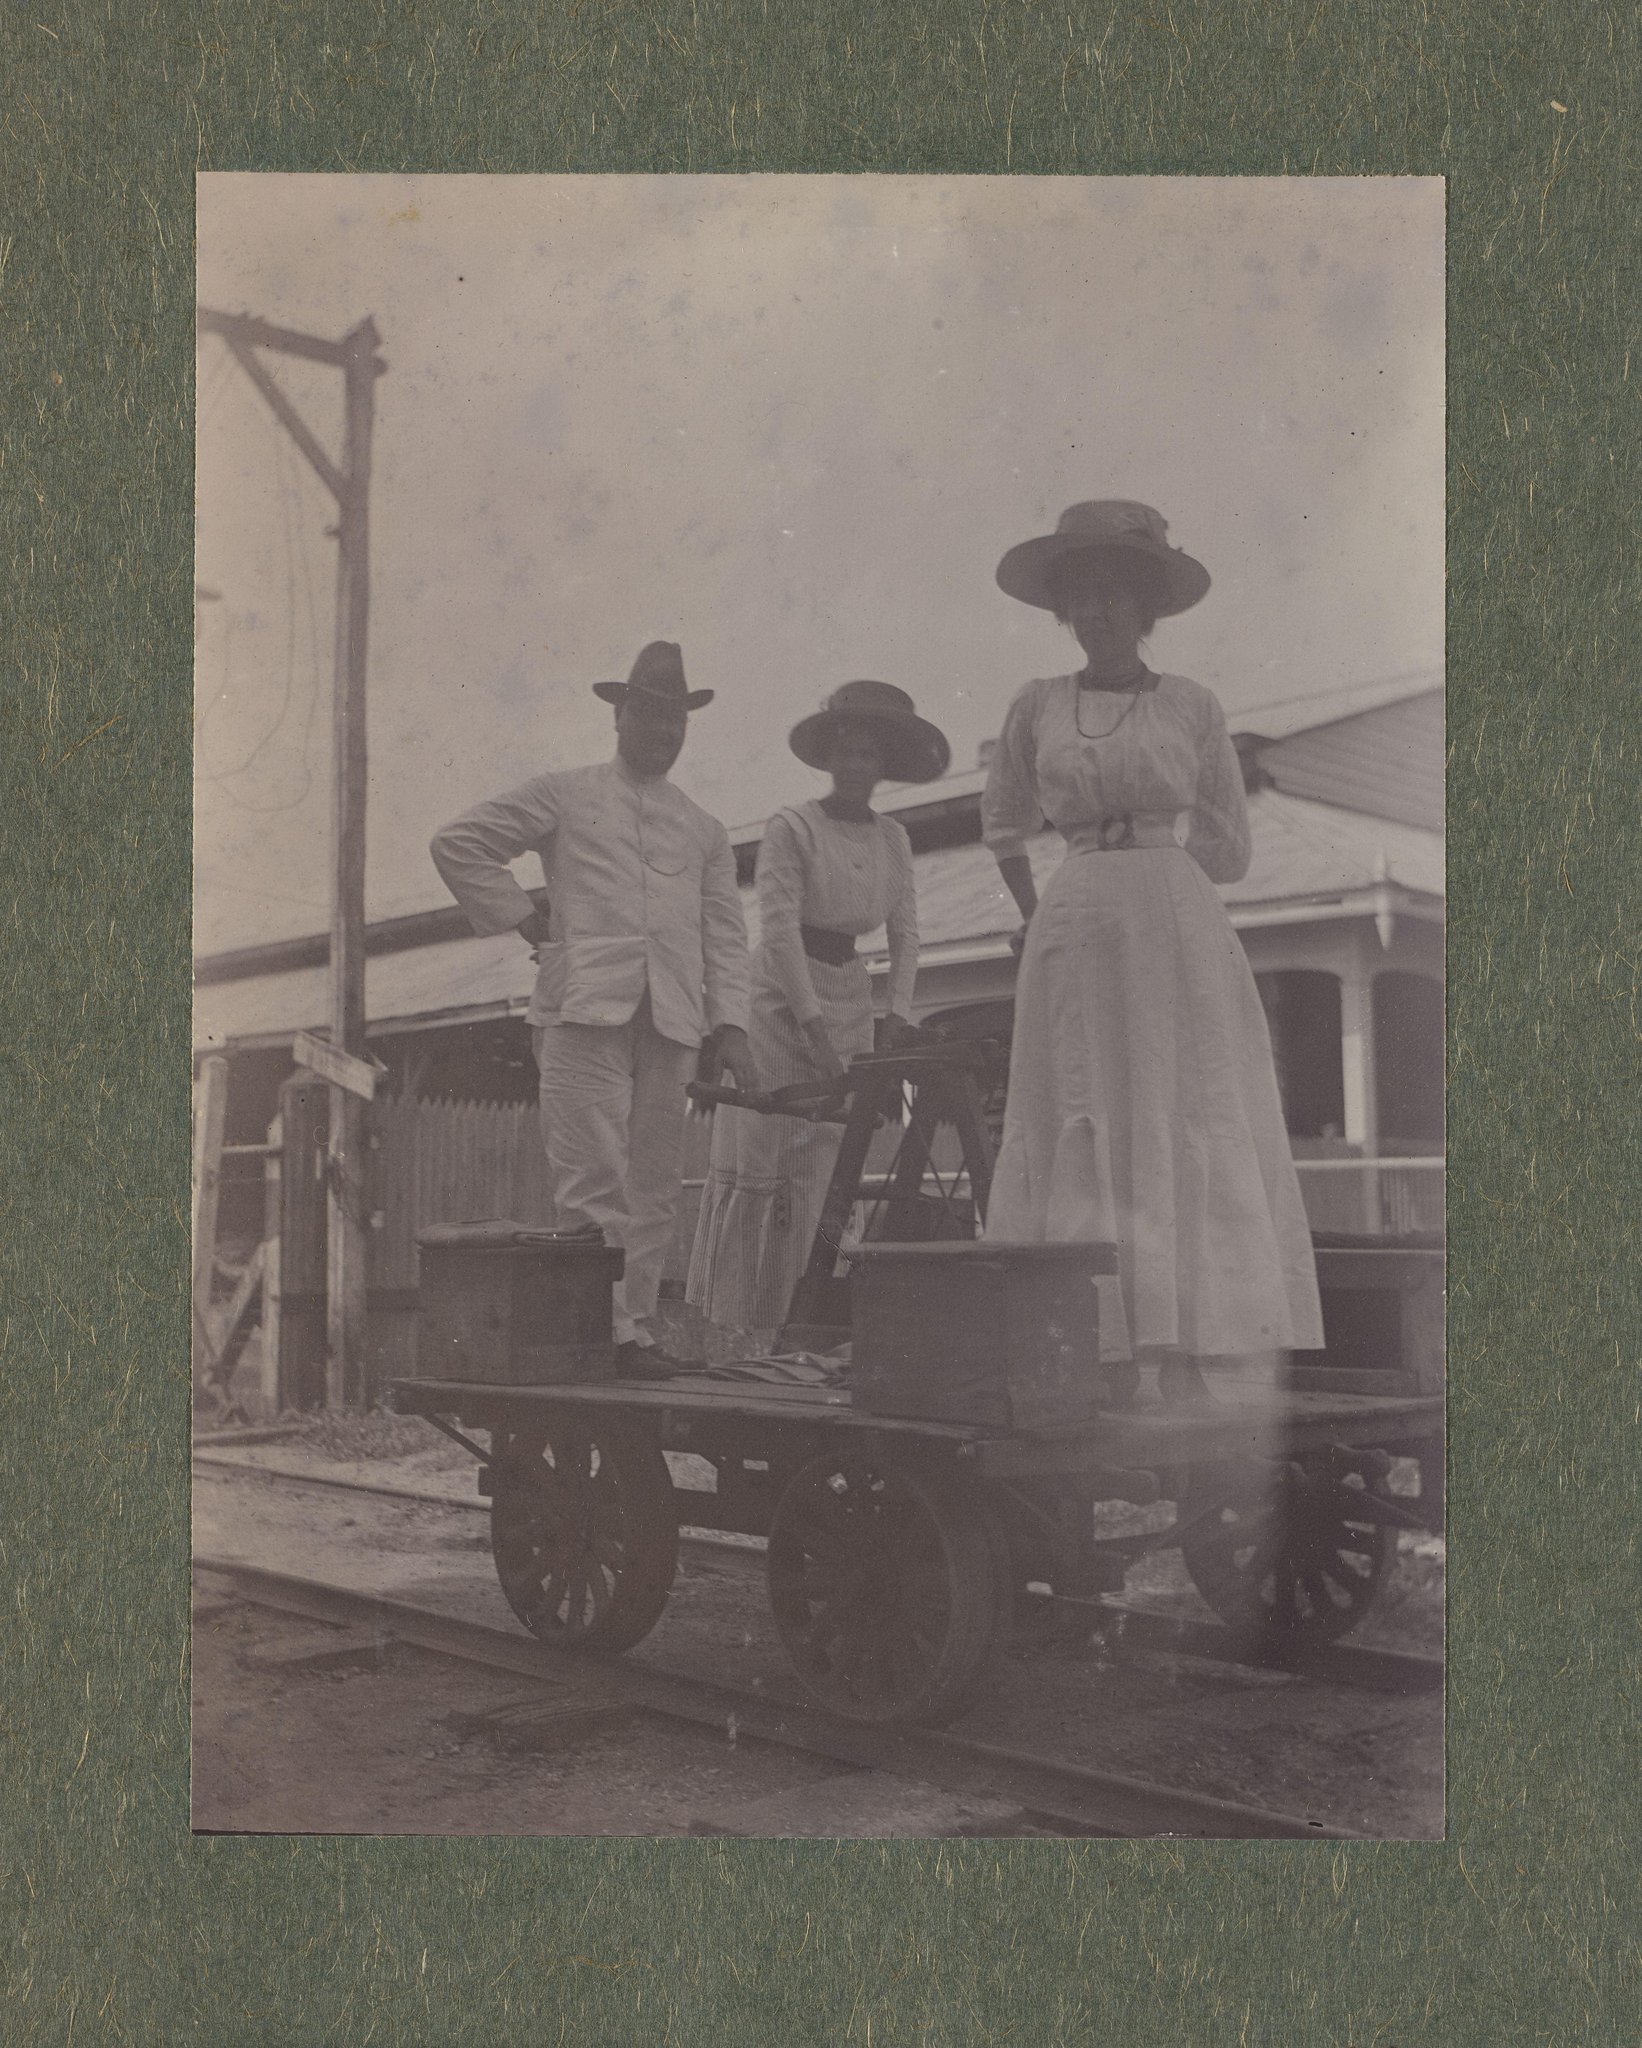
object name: photograph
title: Op een spoorkarretje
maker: Anonymous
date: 1909-1910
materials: photographic support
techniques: gelatin silver print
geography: suriname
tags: suriname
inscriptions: inscription: ‘Marienburg’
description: Maria Gonggrijp met vriend en vriendin op een lorrie of draisine bij de suikerfabriek op Plantage Mariënburg. Onderdeel van het Lloyd fotoalbum van de familie Gonggrijp in de jaren 1909-1910.